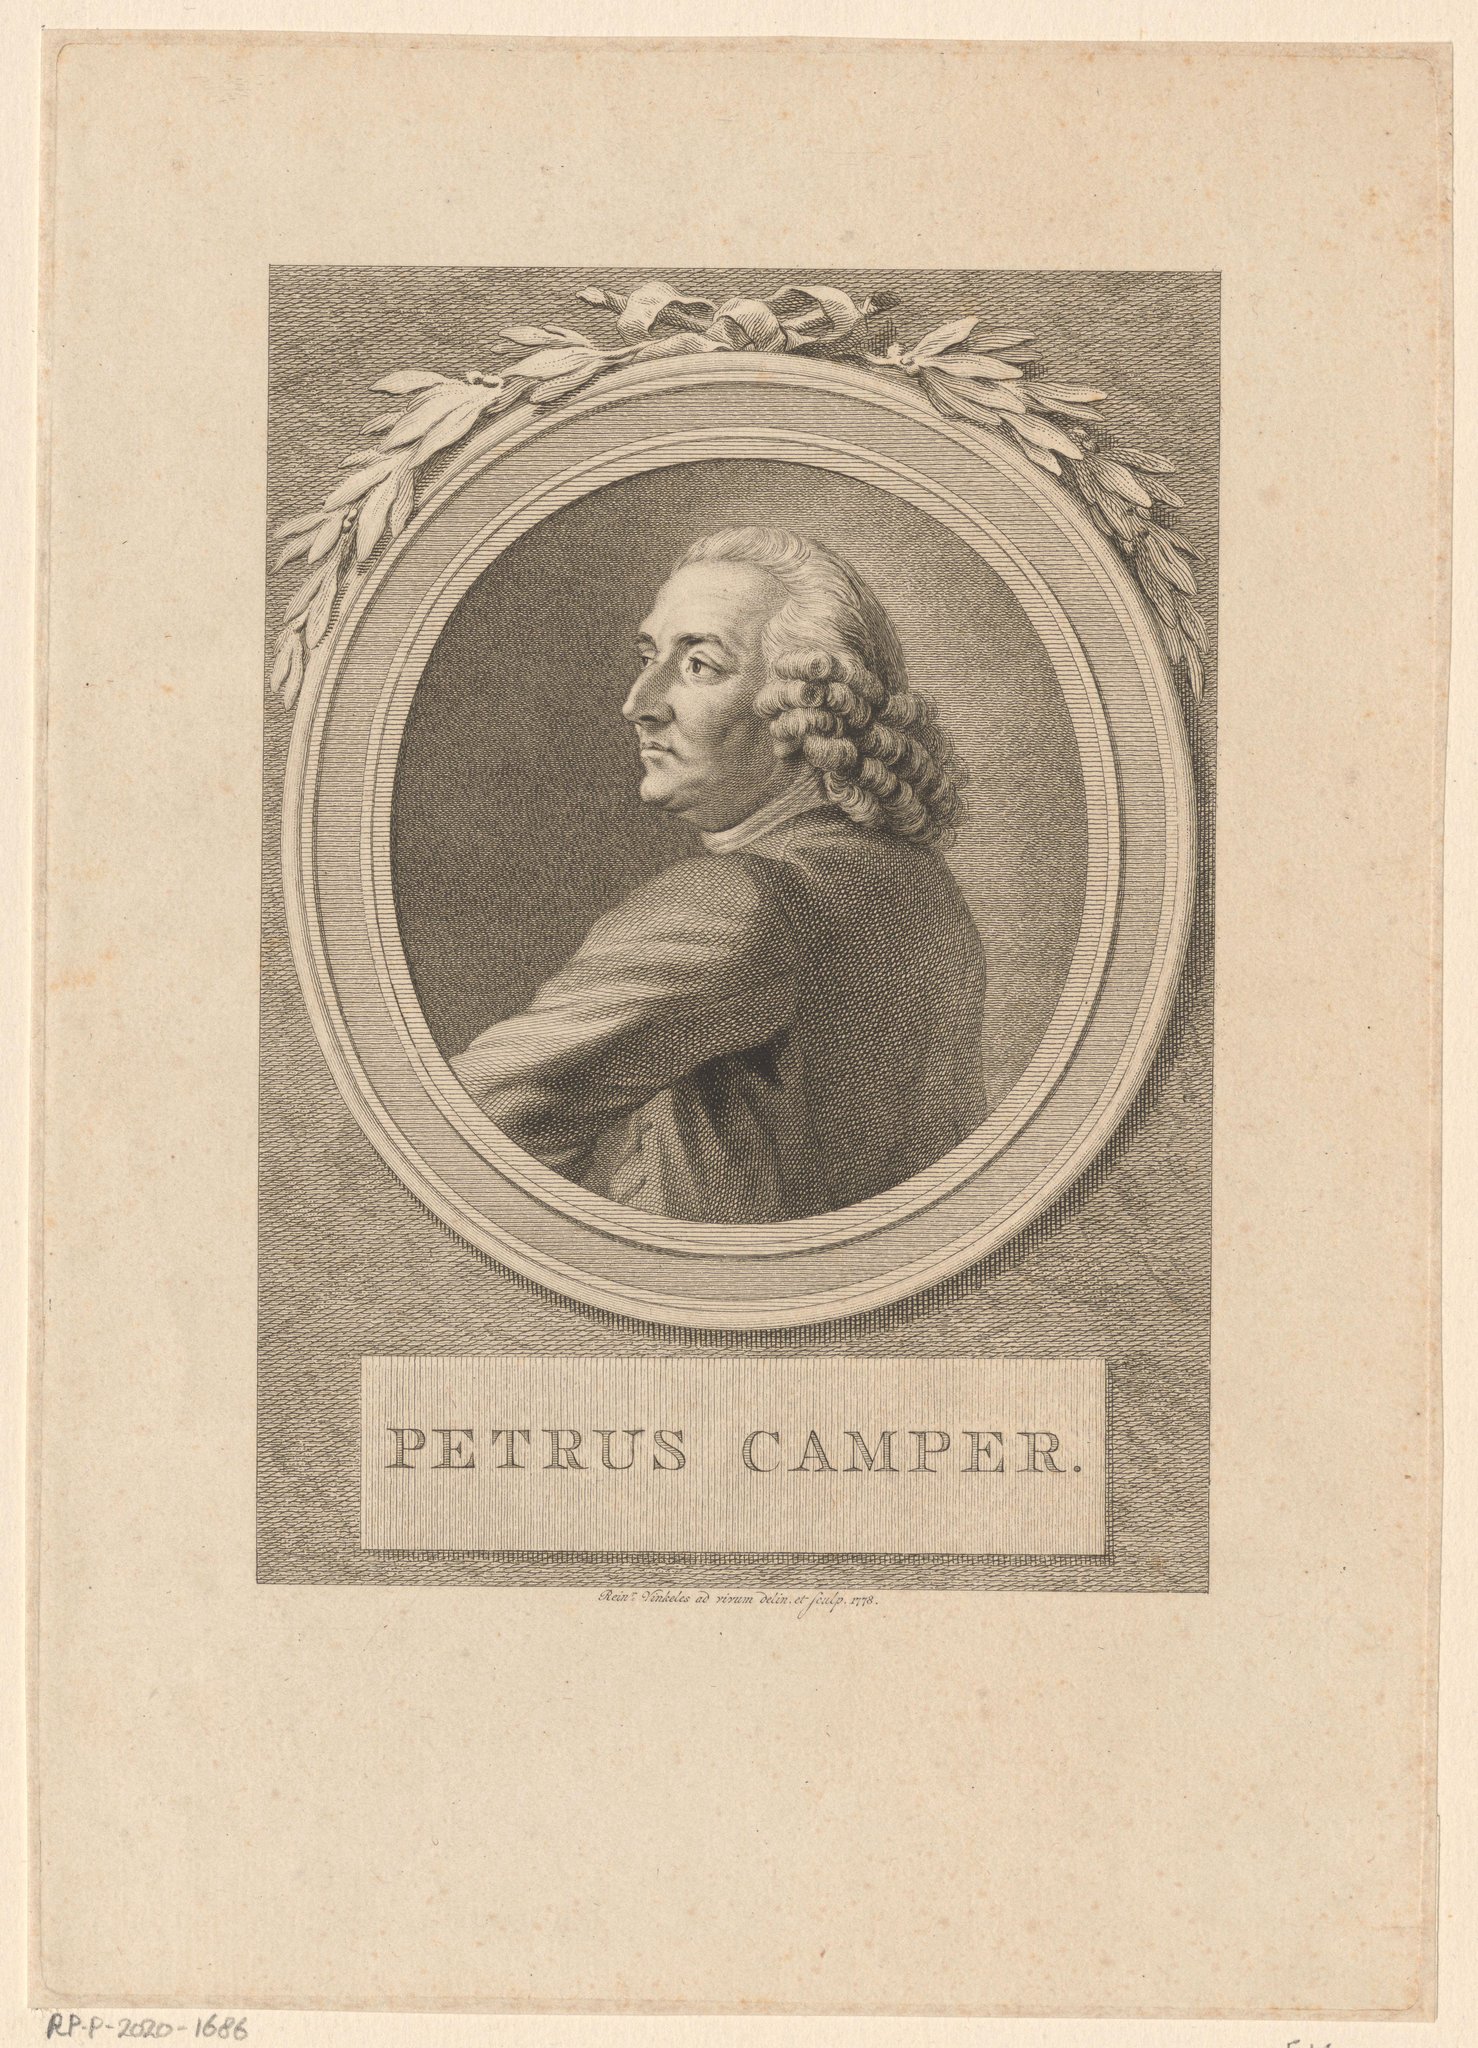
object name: print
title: Portret van Petrus Camper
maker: reinier vinkeles (i)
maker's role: draughtsman, print maker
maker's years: 1741-1816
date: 1778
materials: paper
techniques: engraving, etching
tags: leiden, print maker, draughtsman, petrus camper, historical persons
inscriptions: date